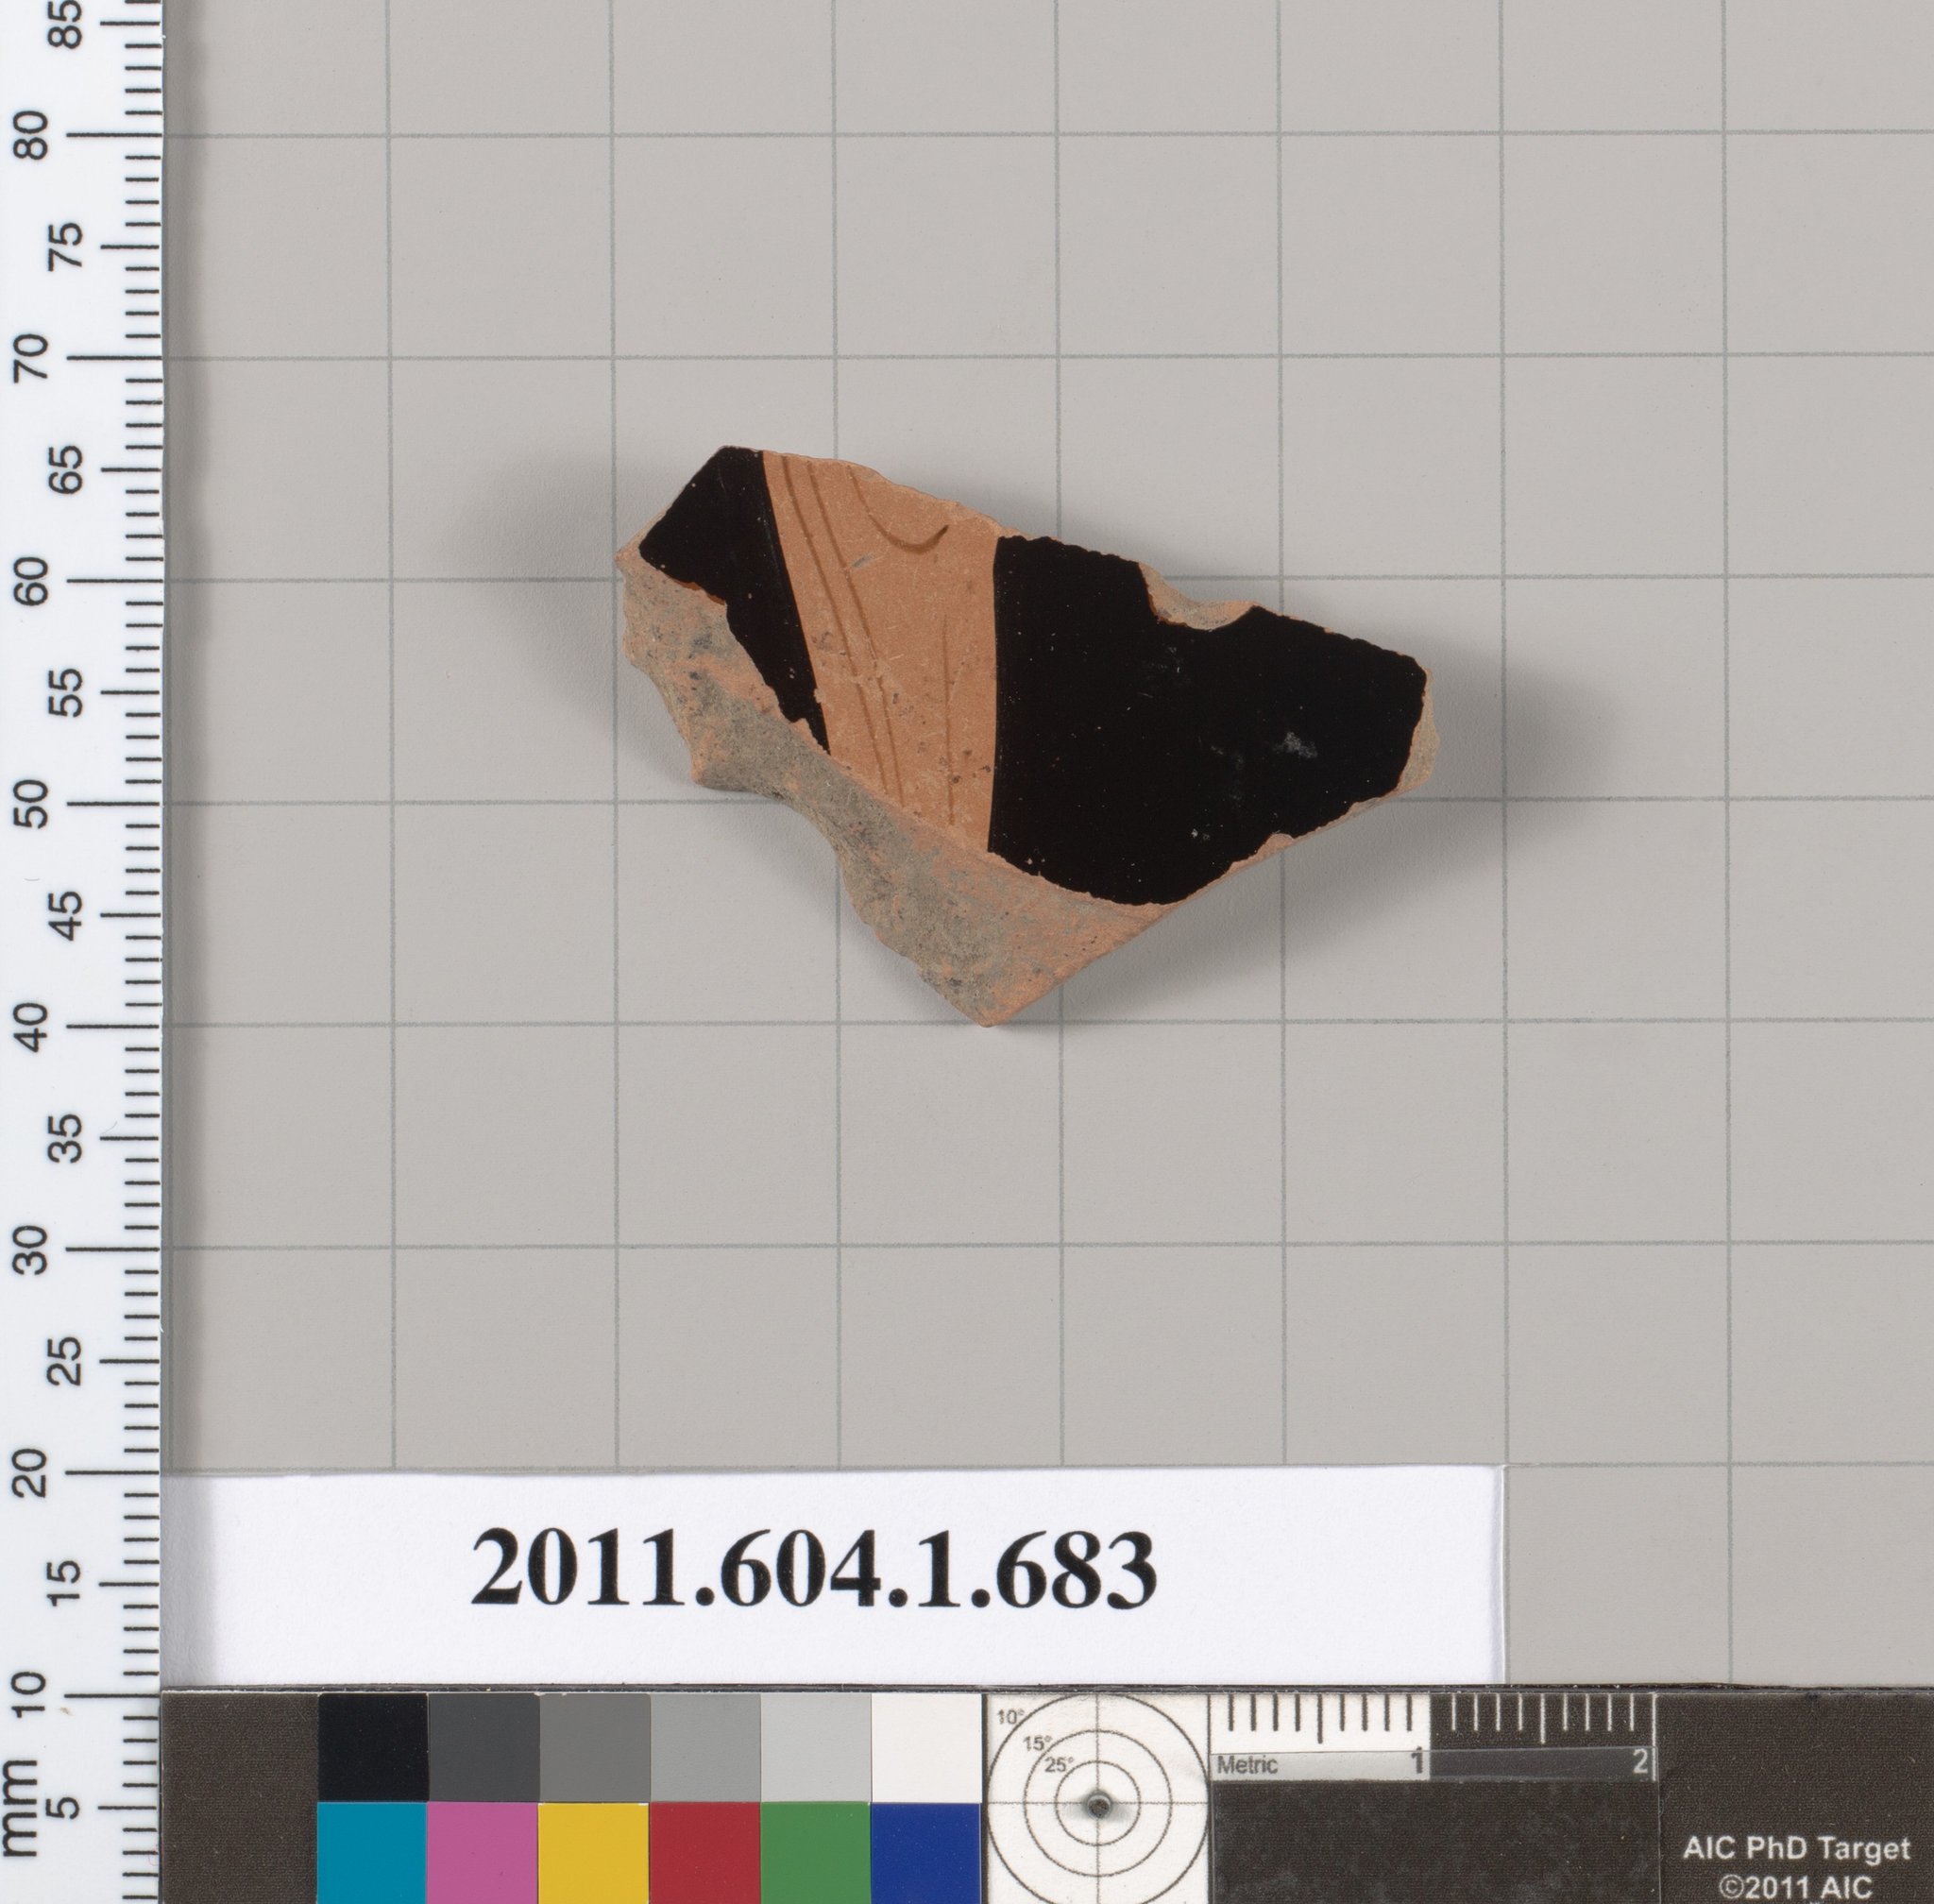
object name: kylix fragment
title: Terracotta fragment of a kylix (drinking cup)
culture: greek, attic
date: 475-451 BCE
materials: terracotta